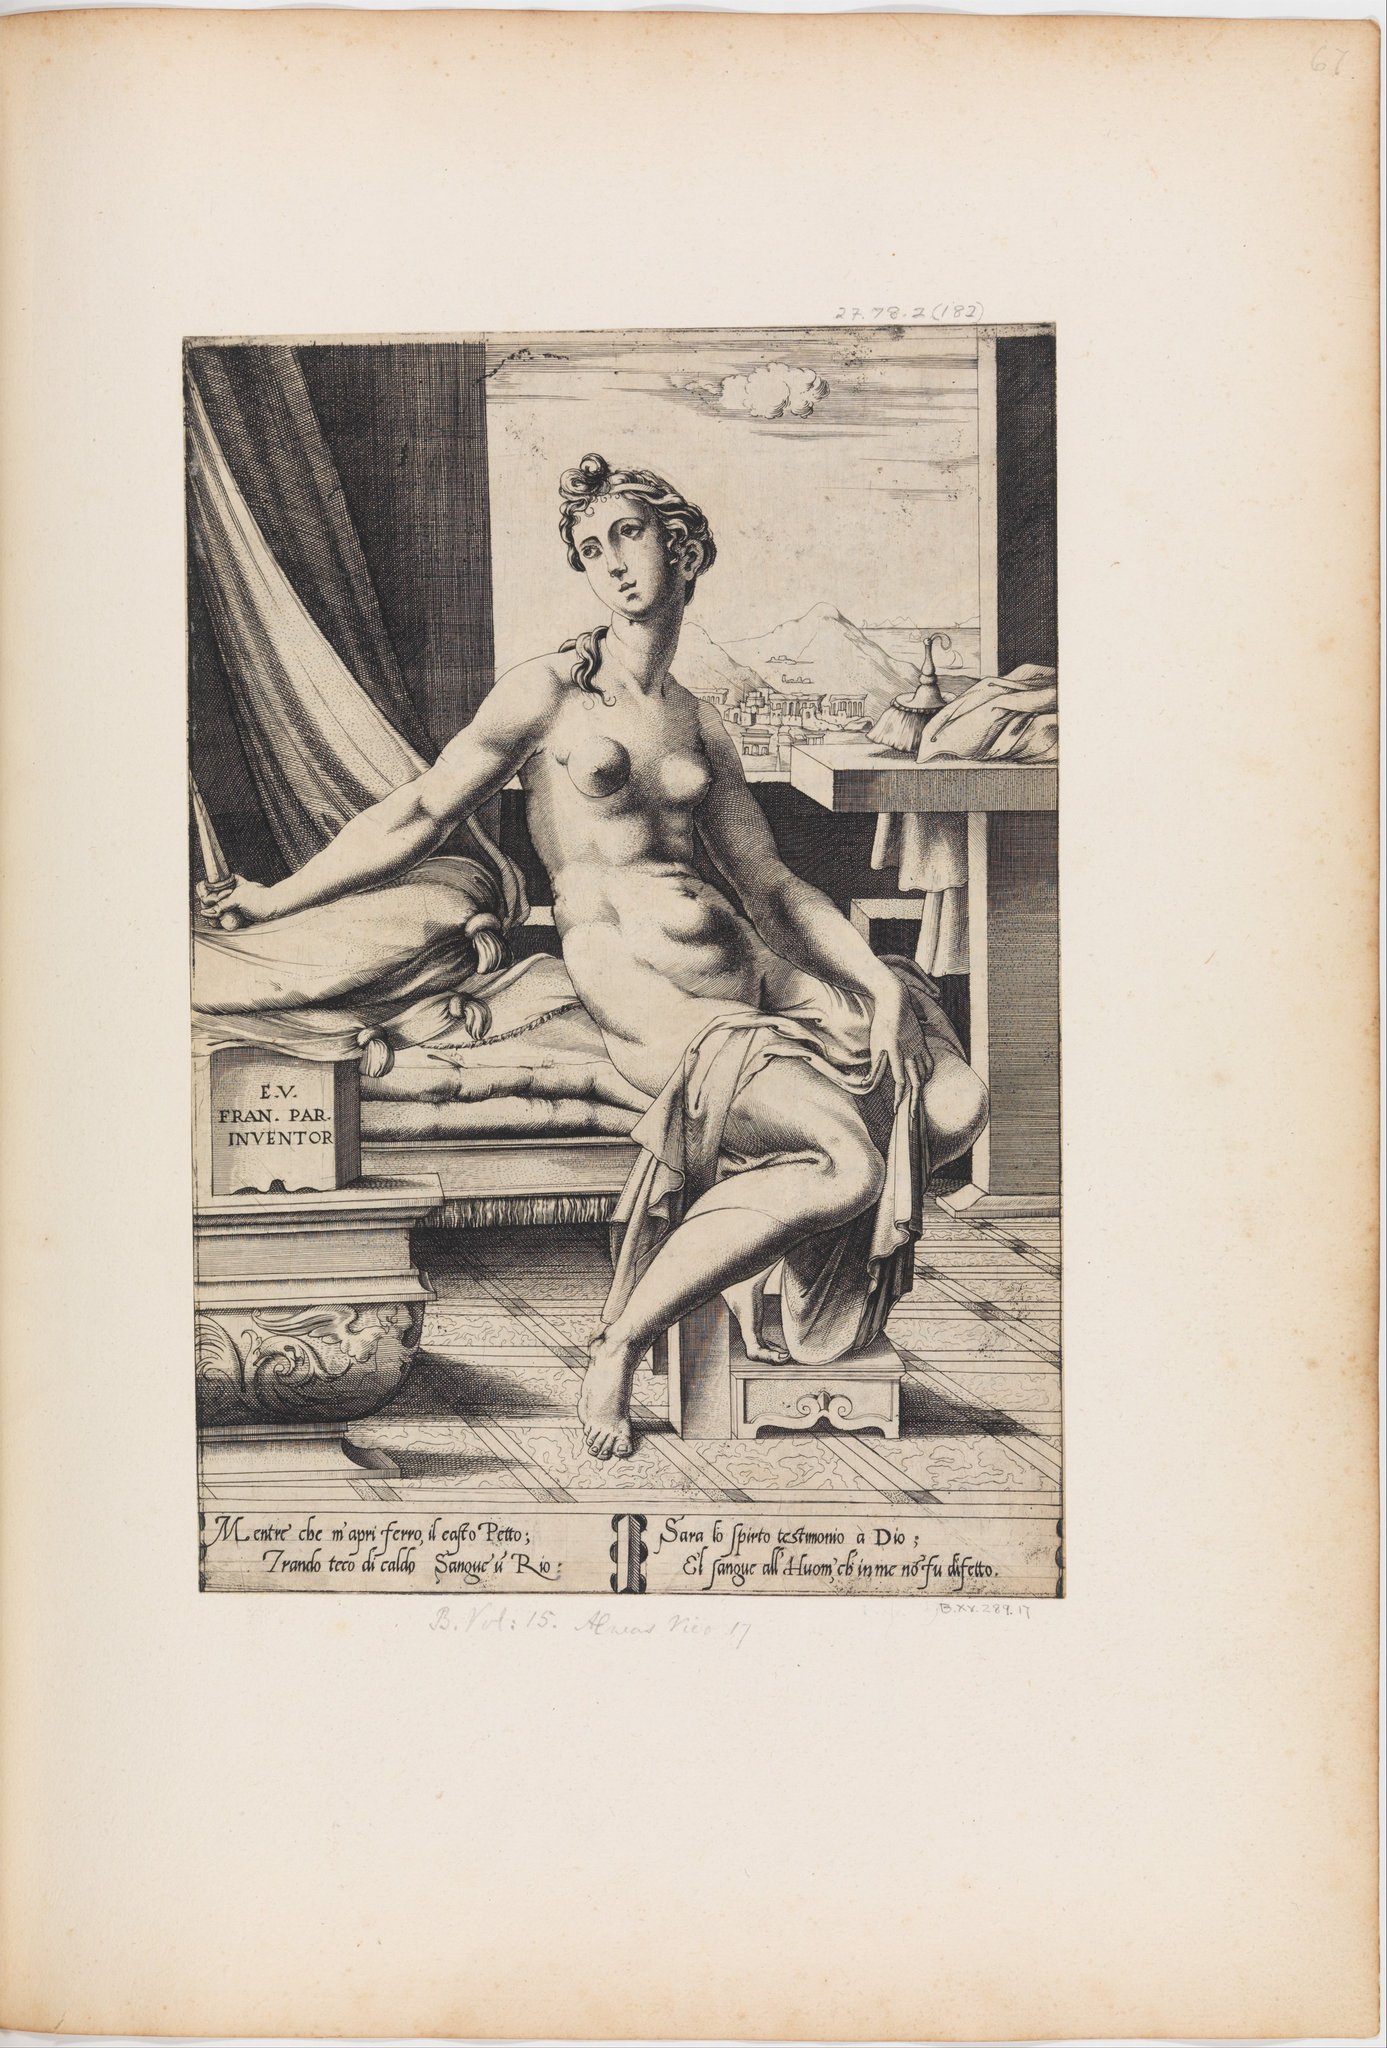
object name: print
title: Lucretia Preparing to Kill Herself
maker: enea vico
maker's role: artist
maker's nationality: italian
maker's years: 1523-1567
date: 1542-1543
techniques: engraving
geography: rome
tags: female nudes